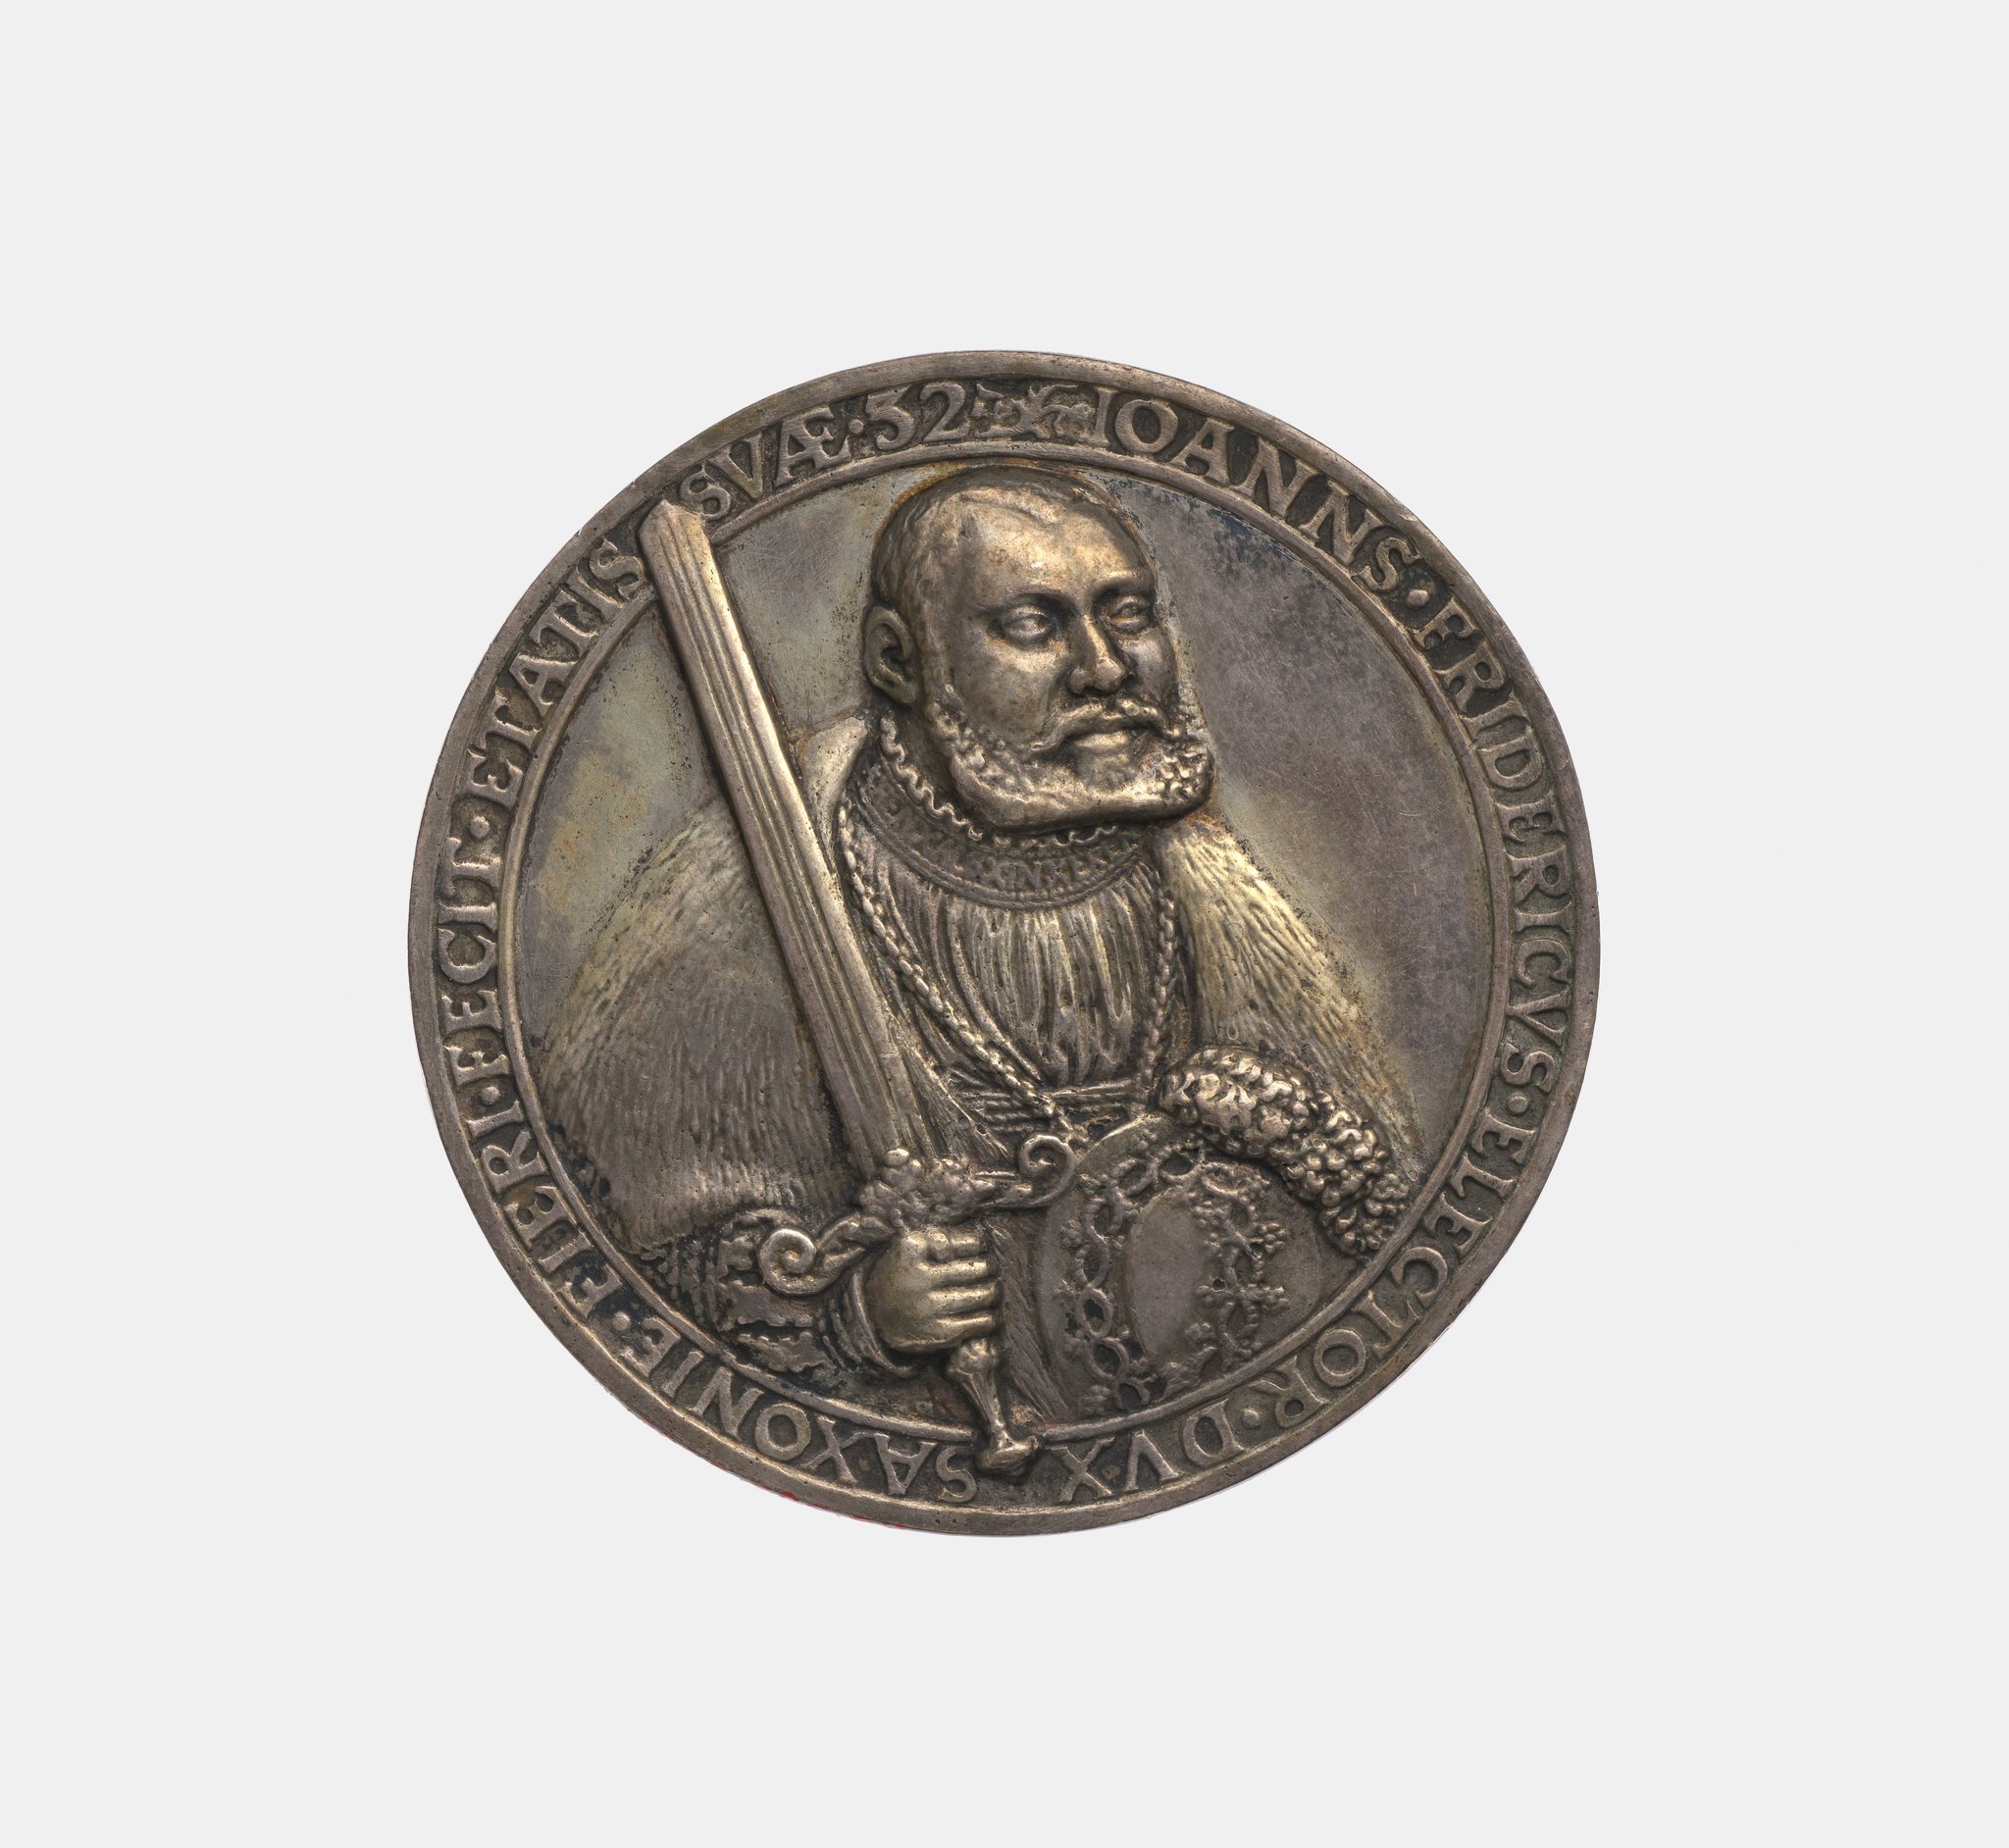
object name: medal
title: John Frederick 1503-54, Elector of Saxony 1532-47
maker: hans reinhart the elder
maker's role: artist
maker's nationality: german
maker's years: 1500-1581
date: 1535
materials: silver